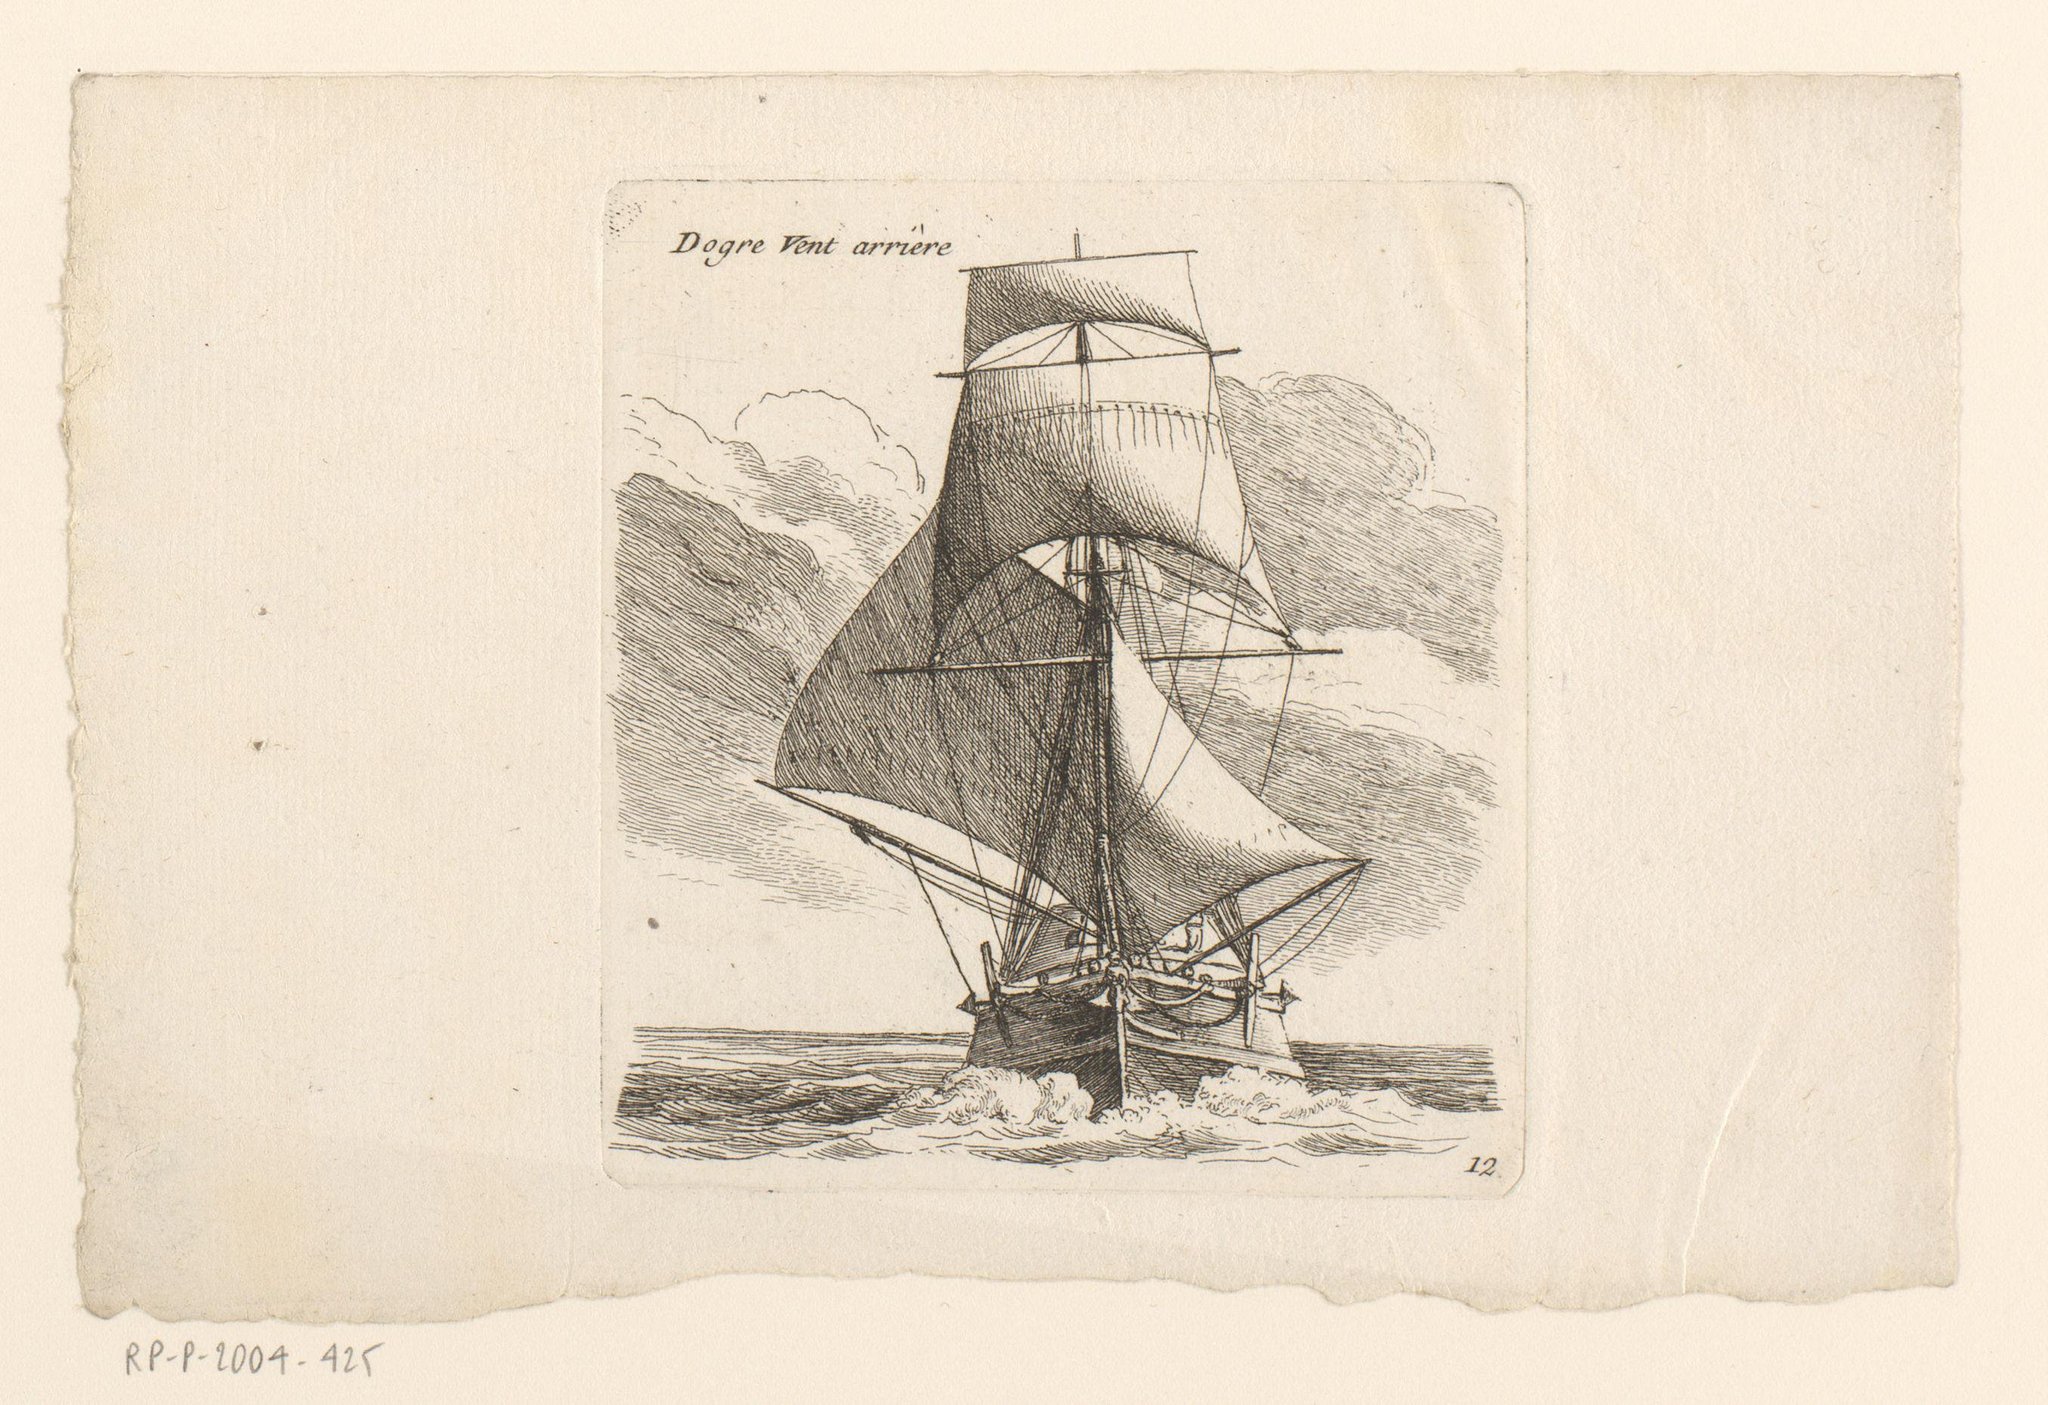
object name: print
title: Dogre Vent arrière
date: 1738-1811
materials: paper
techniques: etching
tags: sailing-ship, sailing-boat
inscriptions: collector's mark: Lugt 2760, collector's mark: Lugt 2228